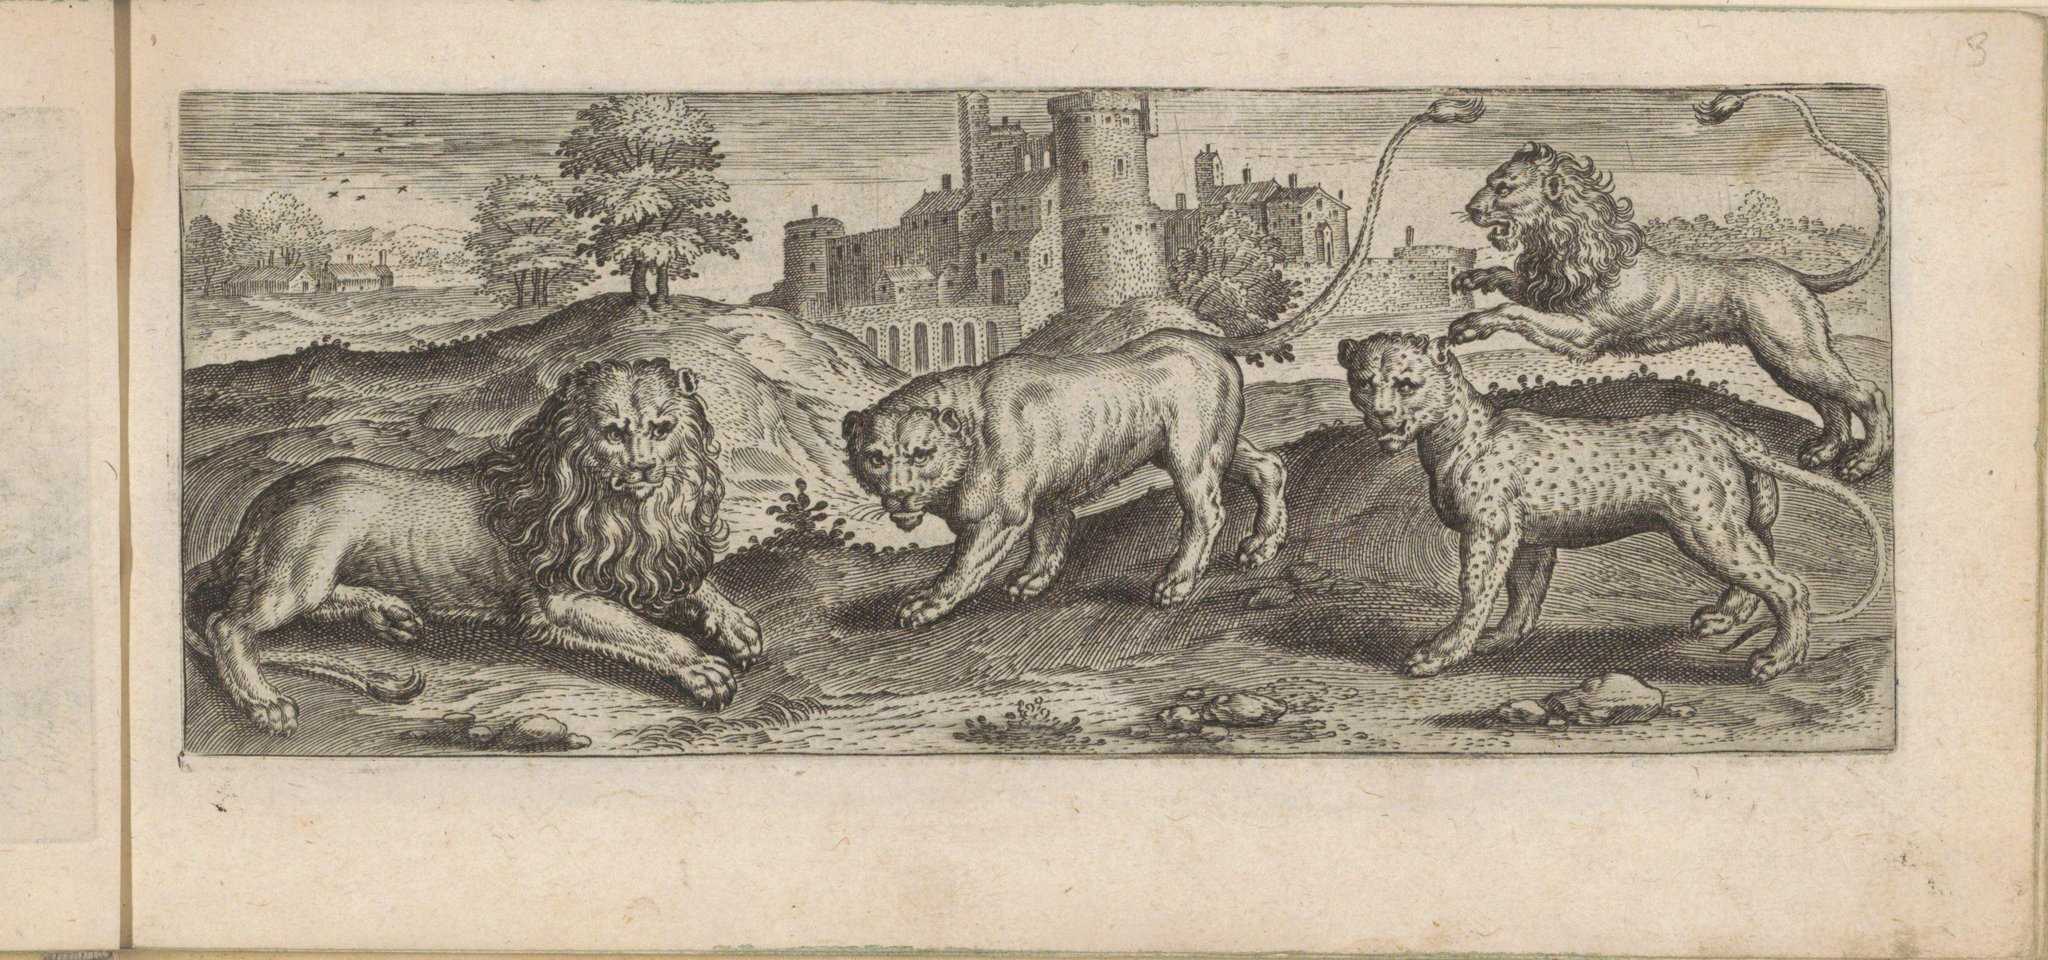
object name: album leaf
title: Animalium Quadrupedum Omnis Generis Verae et Artificiosissimae Delineationes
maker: eduwart van hoeswinckel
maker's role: publisher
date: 1583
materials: paper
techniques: engraving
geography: antwerp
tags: beasts of prey, predatory animals: leopard, landscapes in the temperate zone, beasts of prey, predatory animals: lion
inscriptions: collector's mark: Lugt 2760, collector's mark: Lugt 2228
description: Drie leeuwen en een luipaard in een landschap. Op de achtergrond een burcht. Deze prent maakt deel uit van een album.